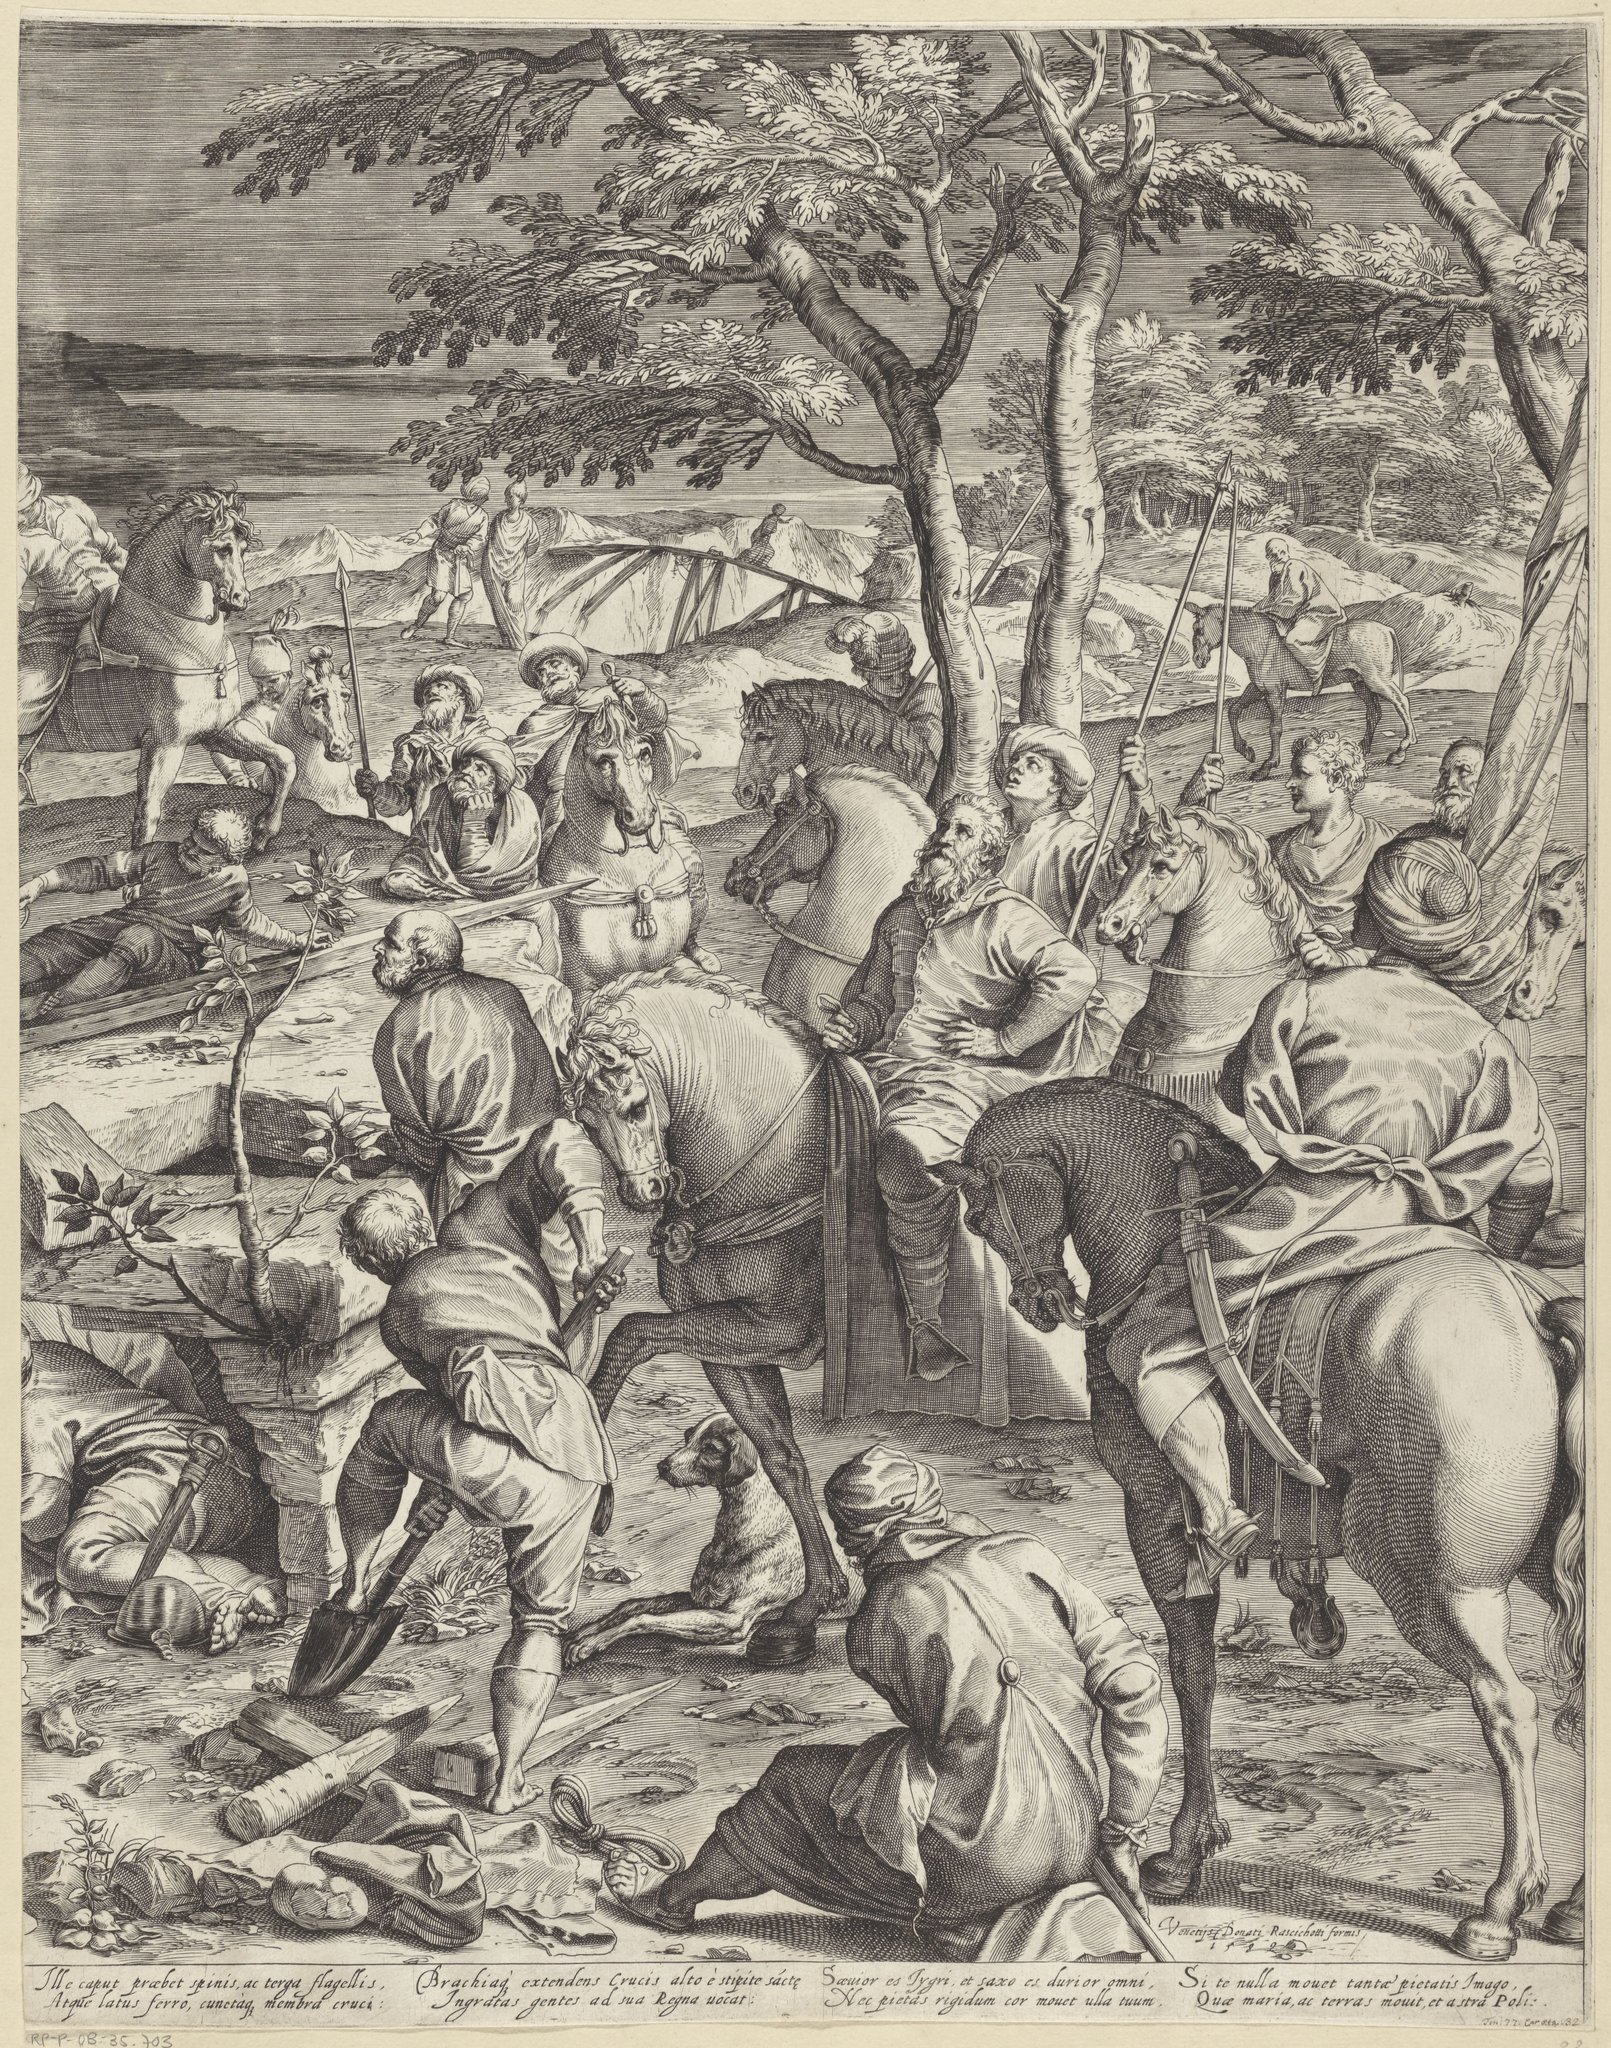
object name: print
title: Kruisiging van Christus (rechterdeel)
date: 1589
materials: paper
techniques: engraving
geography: italy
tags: the crucifixion of christ: christ's death on the cross; golgotha (matthew 27:45-58; mark 15:33-45; luke 23:44-52; john 19:25-38)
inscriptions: collector's mark: Lugt 240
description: Kruisdood van Christus op Golgota. Christus hangt aan het kruis, links en rechts van hem worden de twee misdadigers gekruisigd. Longinus staat op het punt zijn lans in de zijde van Christus te steken. Een groep mannen op paarden en ezels kijkt toe. De Maria's en Johannes treuren onder het kruis. Tekst in het Latijn in ondermarge.